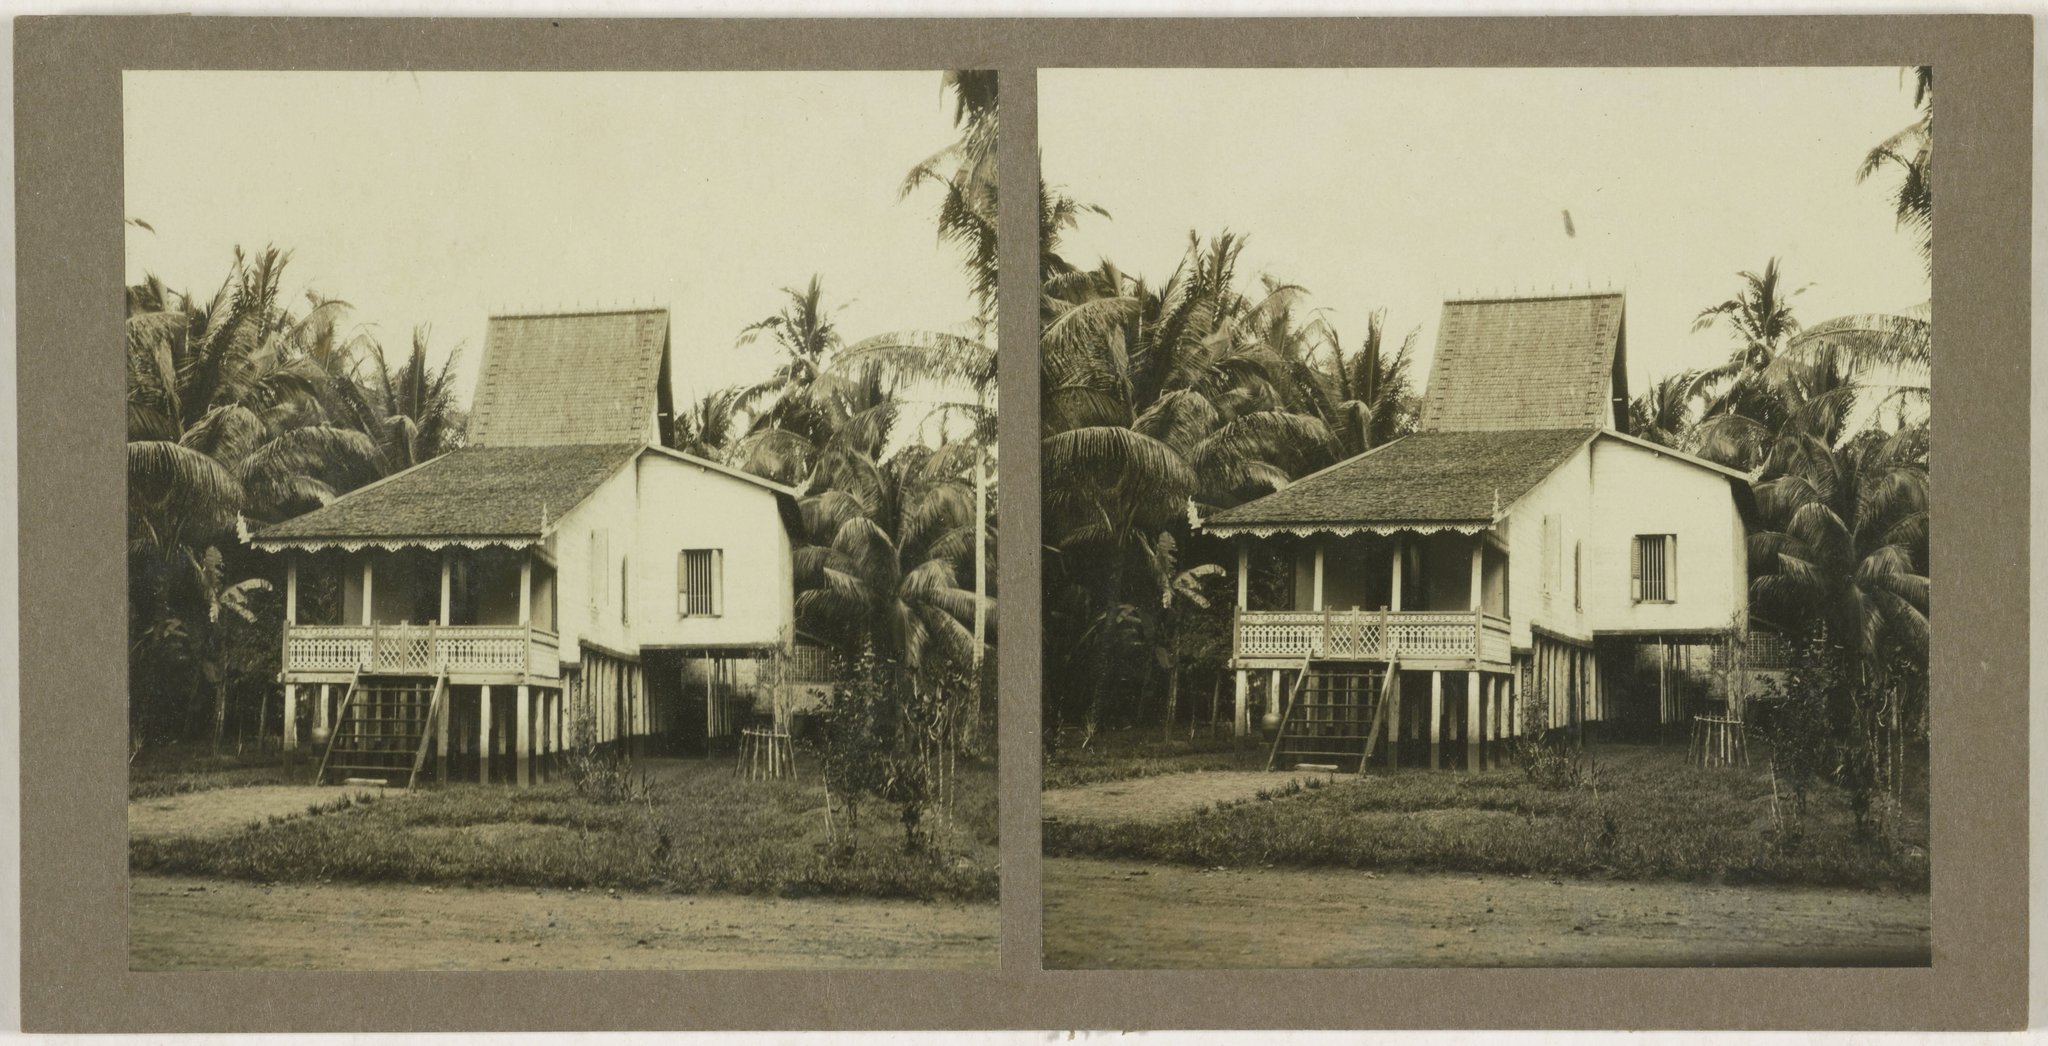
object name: stereograph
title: Woonhuis in bosachtige omgeving, mogelijk op Borneo, Indonesië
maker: Anonymous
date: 1900-1940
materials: paper, cardboard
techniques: gelatin silver print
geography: indonesia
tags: country-house, indonesia